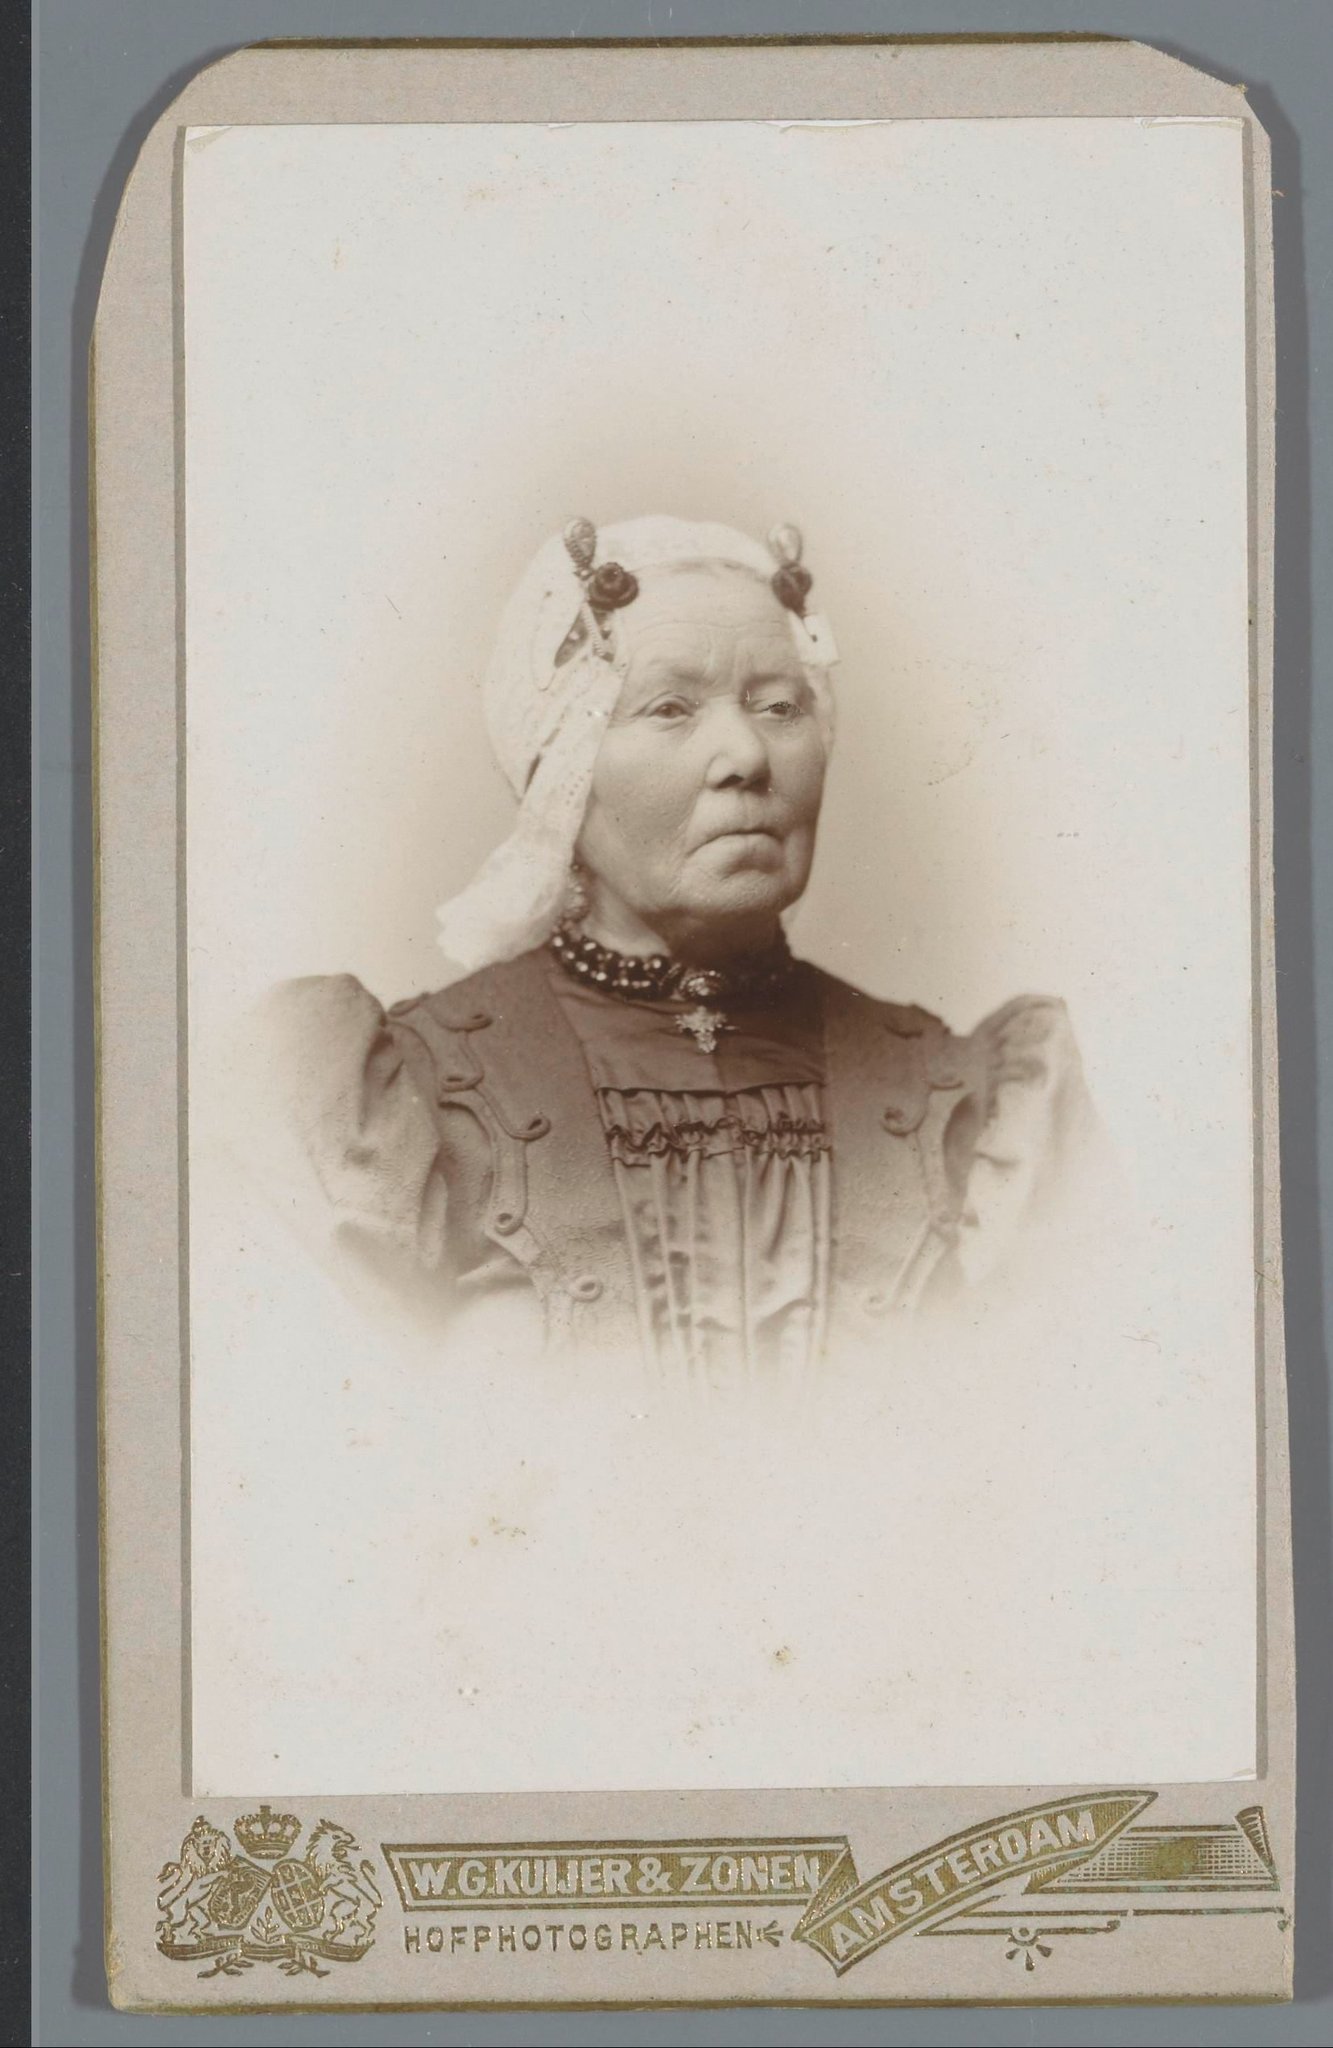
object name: carte de visite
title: Portret van Trijntje Ton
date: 1890-1906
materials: paper, cardboard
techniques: gelatin silver print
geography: amsterdam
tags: adult woman, historical persons, amsterdam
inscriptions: address: ‘Amsterdam/ westermarkt 19.’, inscription: ‘OPGERICHT 1864/ Speciale Inrichting/ voor/ VERGROOTINGEN/ in alle Formaten./ Prager & Lojda.Berlin/ 30599’